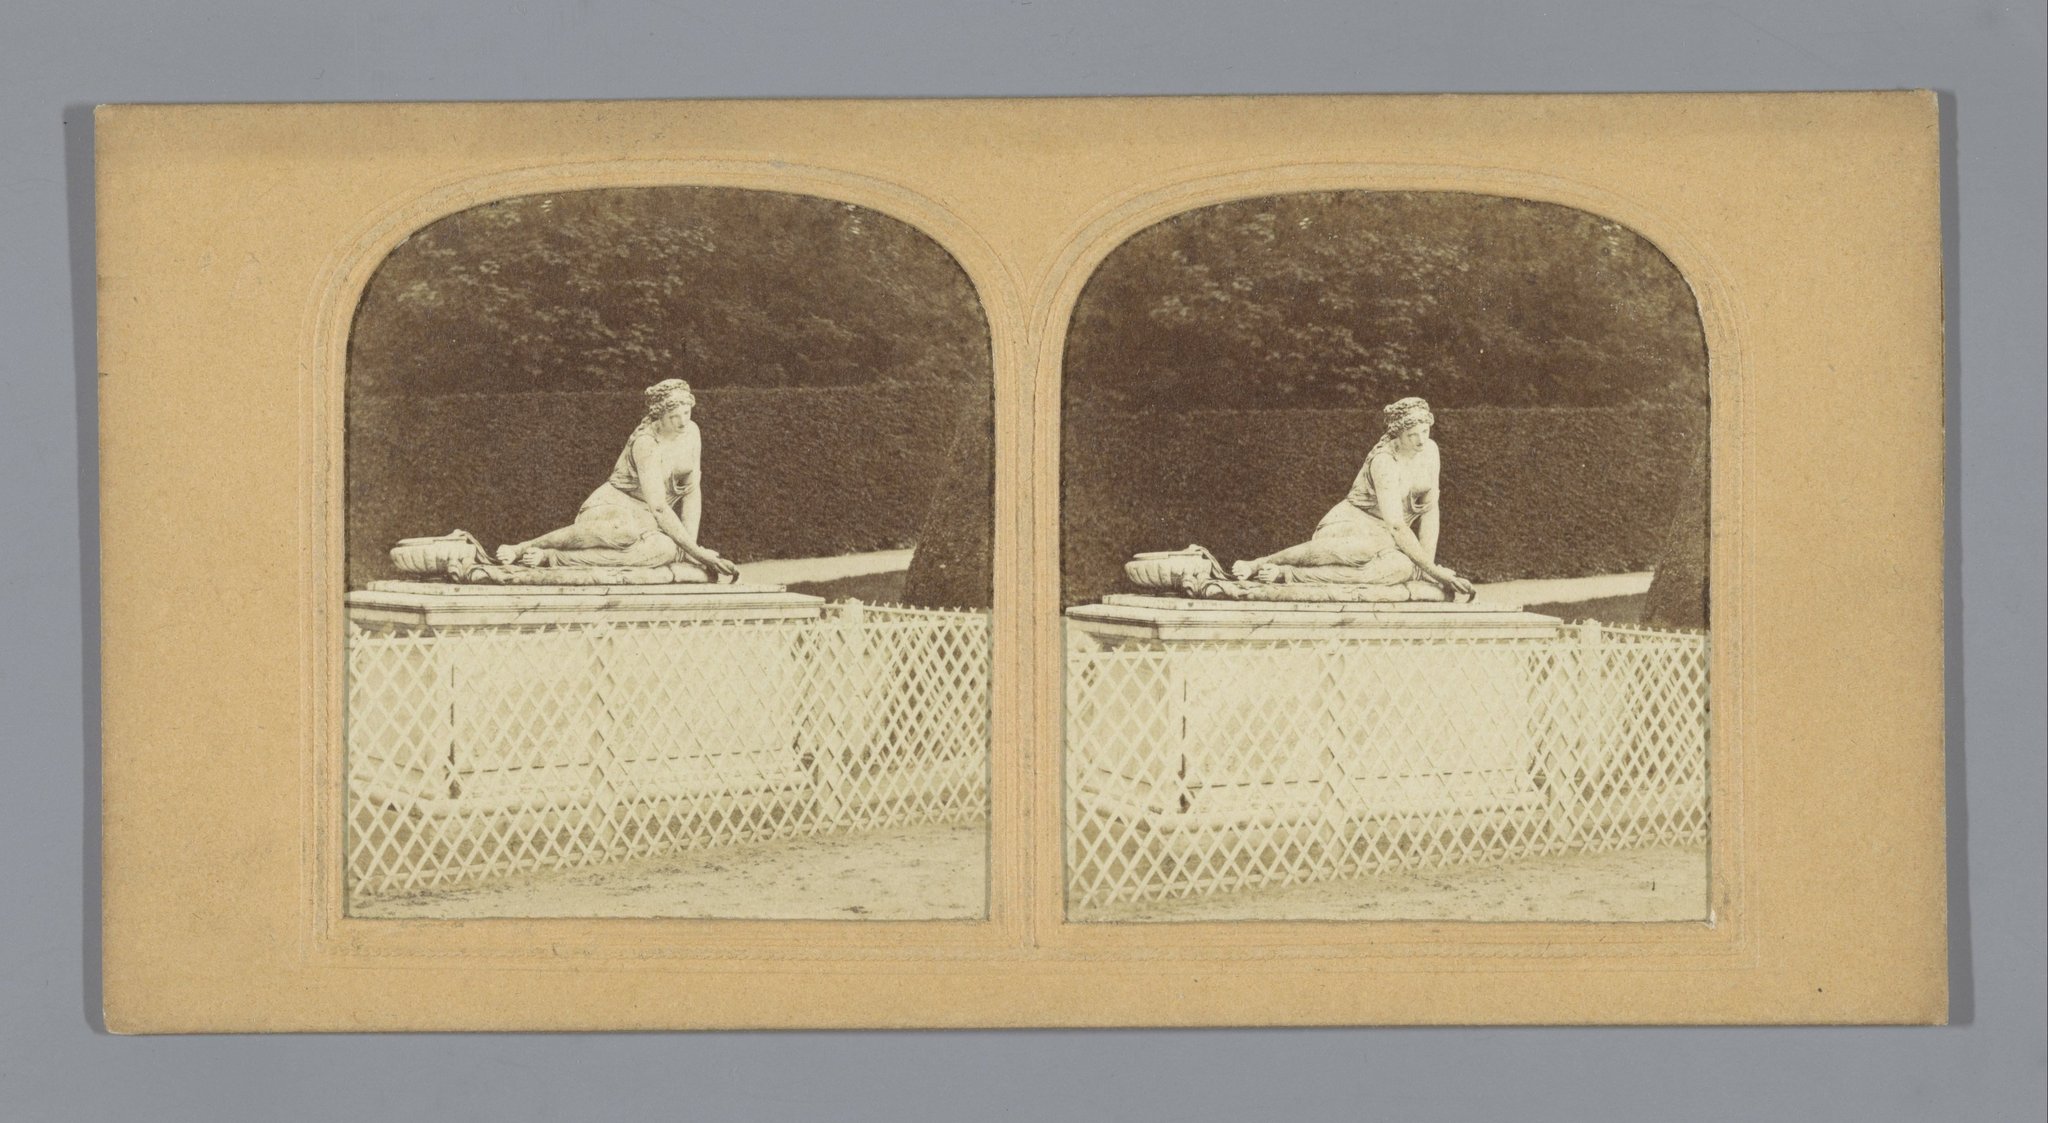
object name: tissue stereograph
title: La Venus à la Coquille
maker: Anonymous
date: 1855-1875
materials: cardboard, paper, photographic support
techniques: albumen print, hand coloring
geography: versailles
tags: sculpture